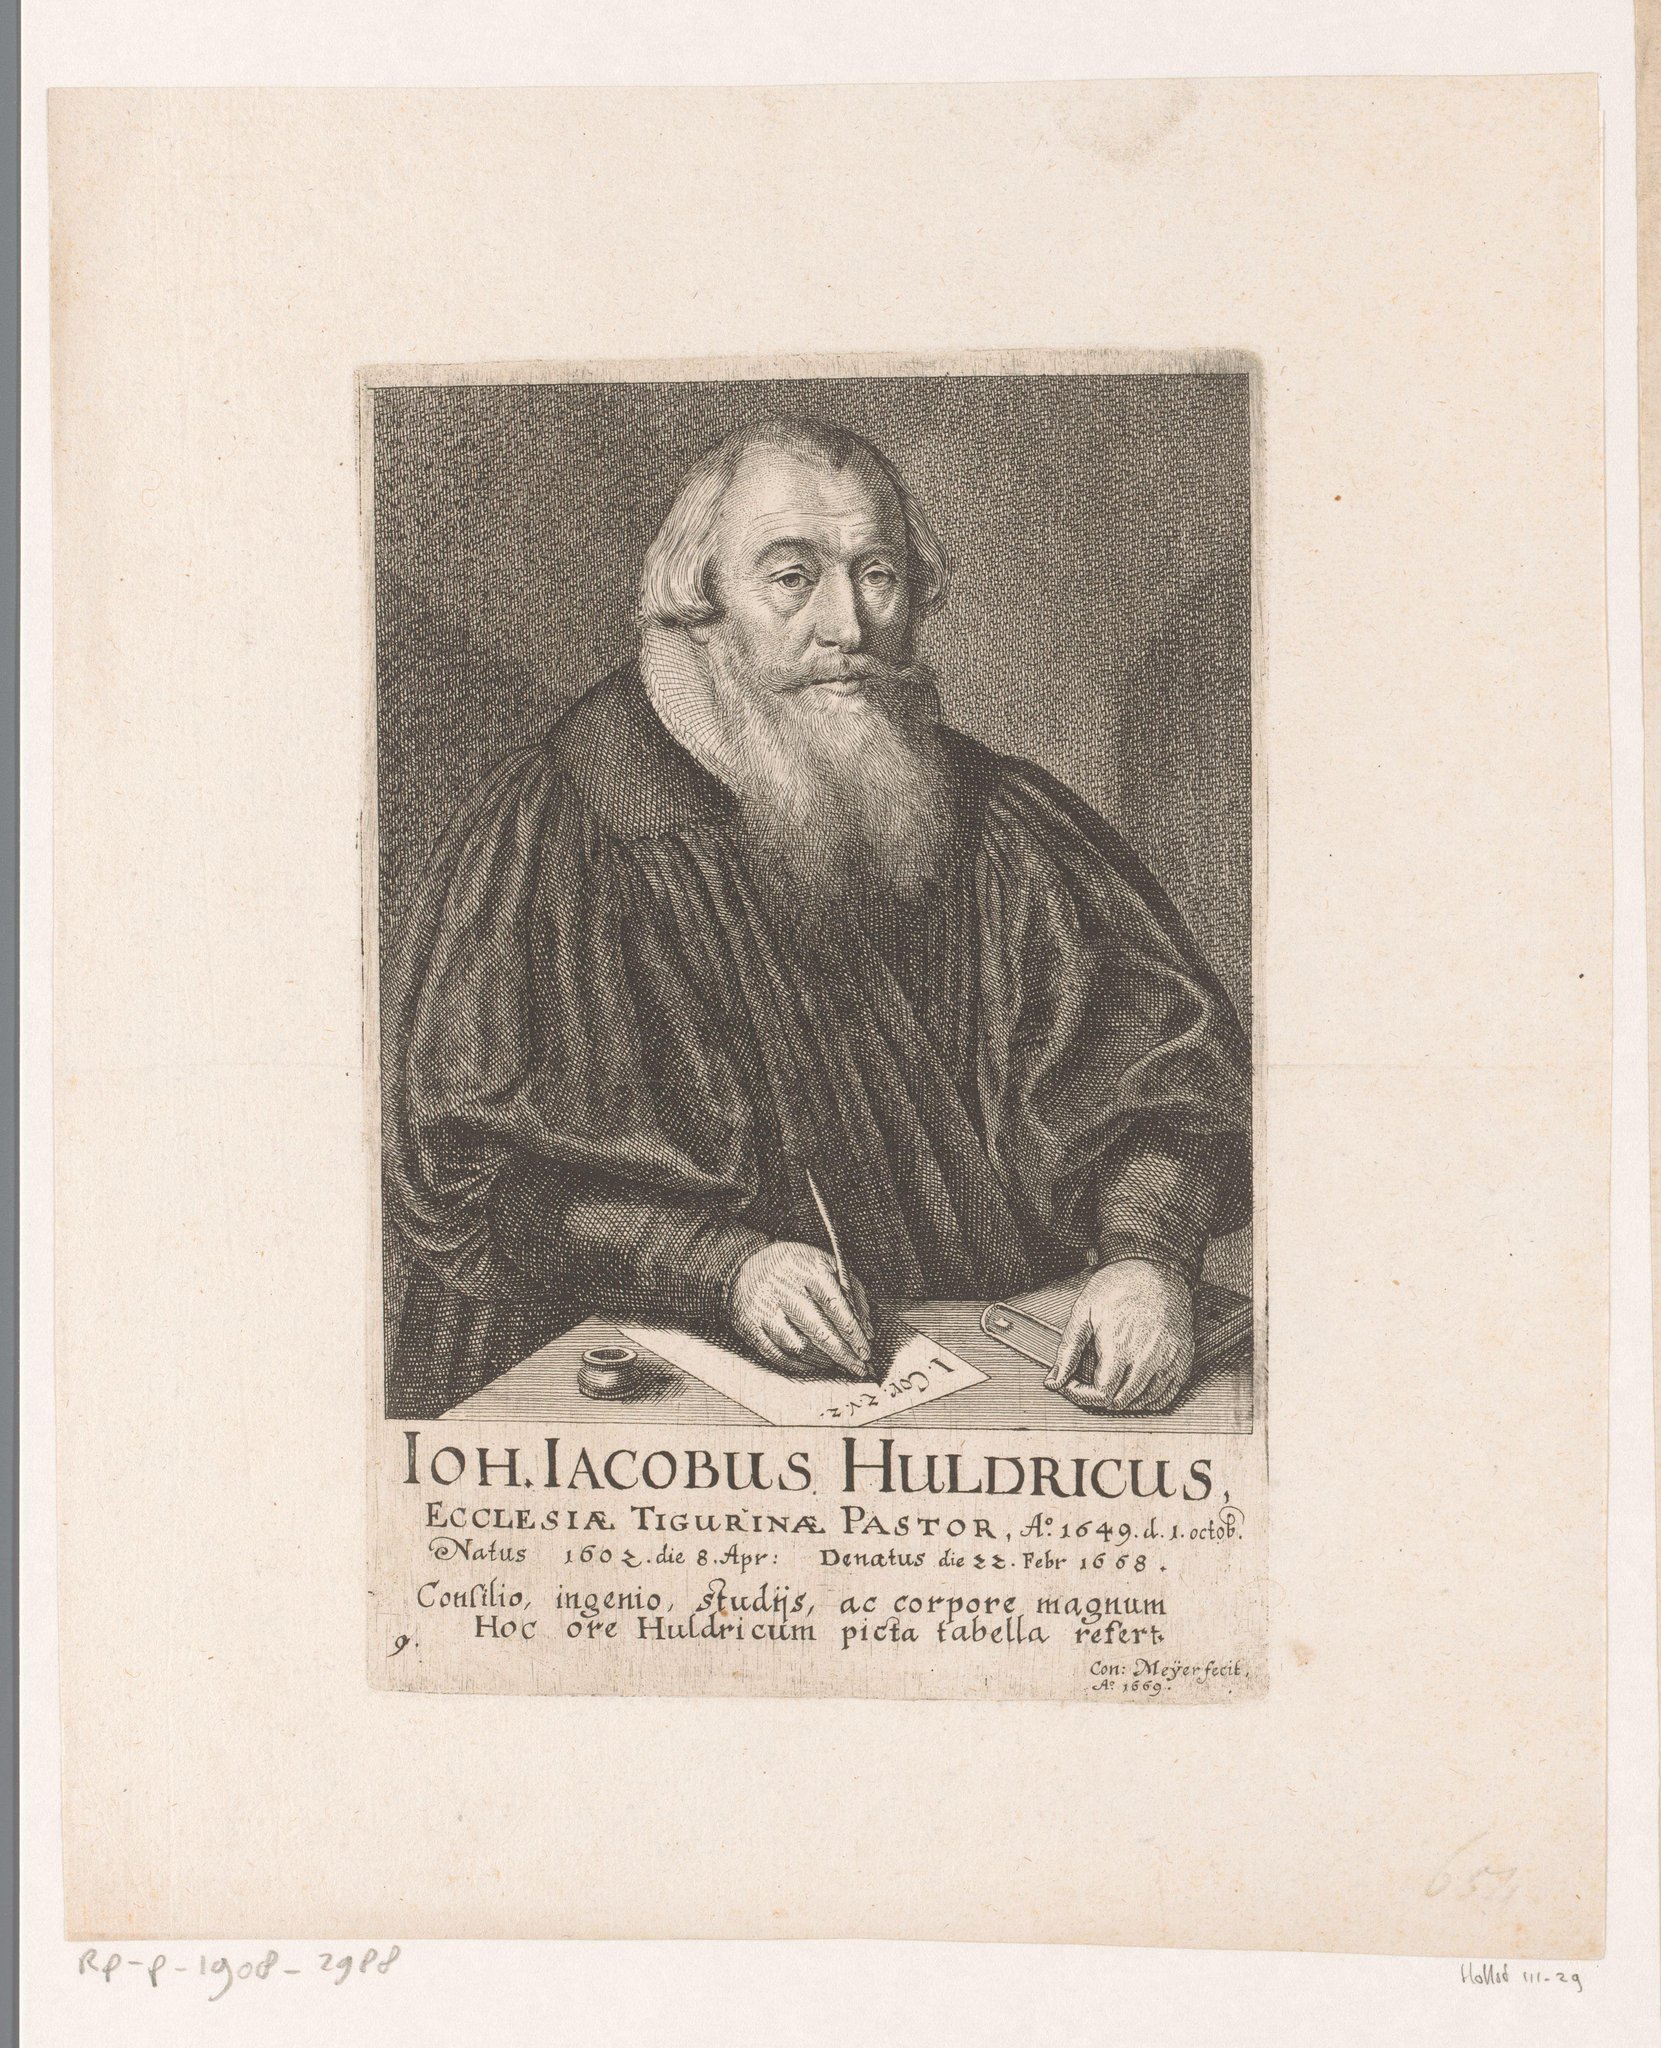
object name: print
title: Portretten van priesters van Zürich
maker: conrad meyer (i)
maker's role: painter, print maker, publisher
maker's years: 1618-1689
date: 1669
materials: paper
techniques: engraving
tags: theologian, historical persons, book, paper (writing material)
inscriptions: collector's mark: Lugt 2228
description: Onderdeel van een serie van 62 portretten van priesters en theologen van Zürich. Zie Hollstein German 111, 1-41.